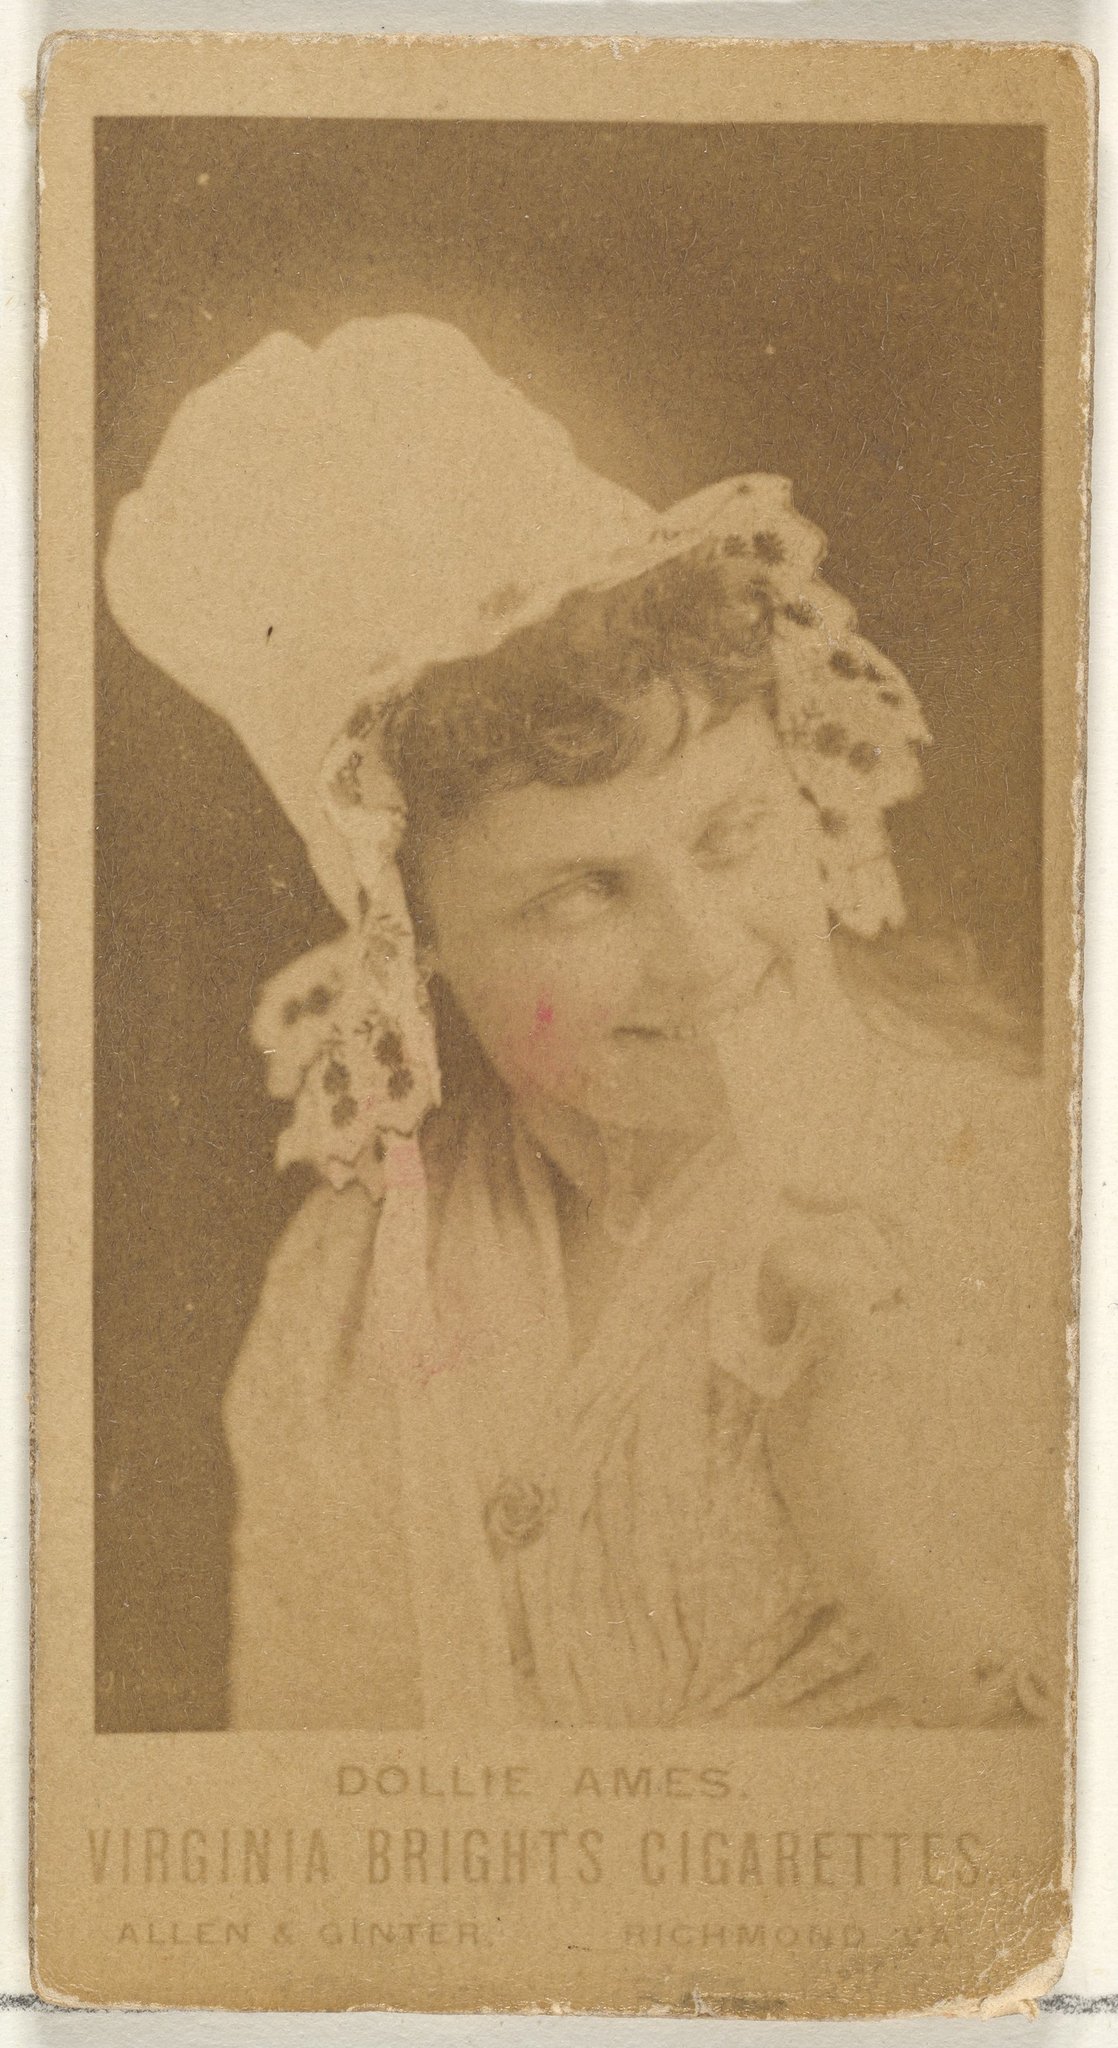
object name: photograph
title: Dollie Ames, from the Actors and Actresses series (N45, Type 1) for Virginia Brights Cigarettes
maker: allen & ginter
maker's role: publisher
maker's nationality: american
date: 1888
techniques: albumen silver print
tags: portraits,women,actresses